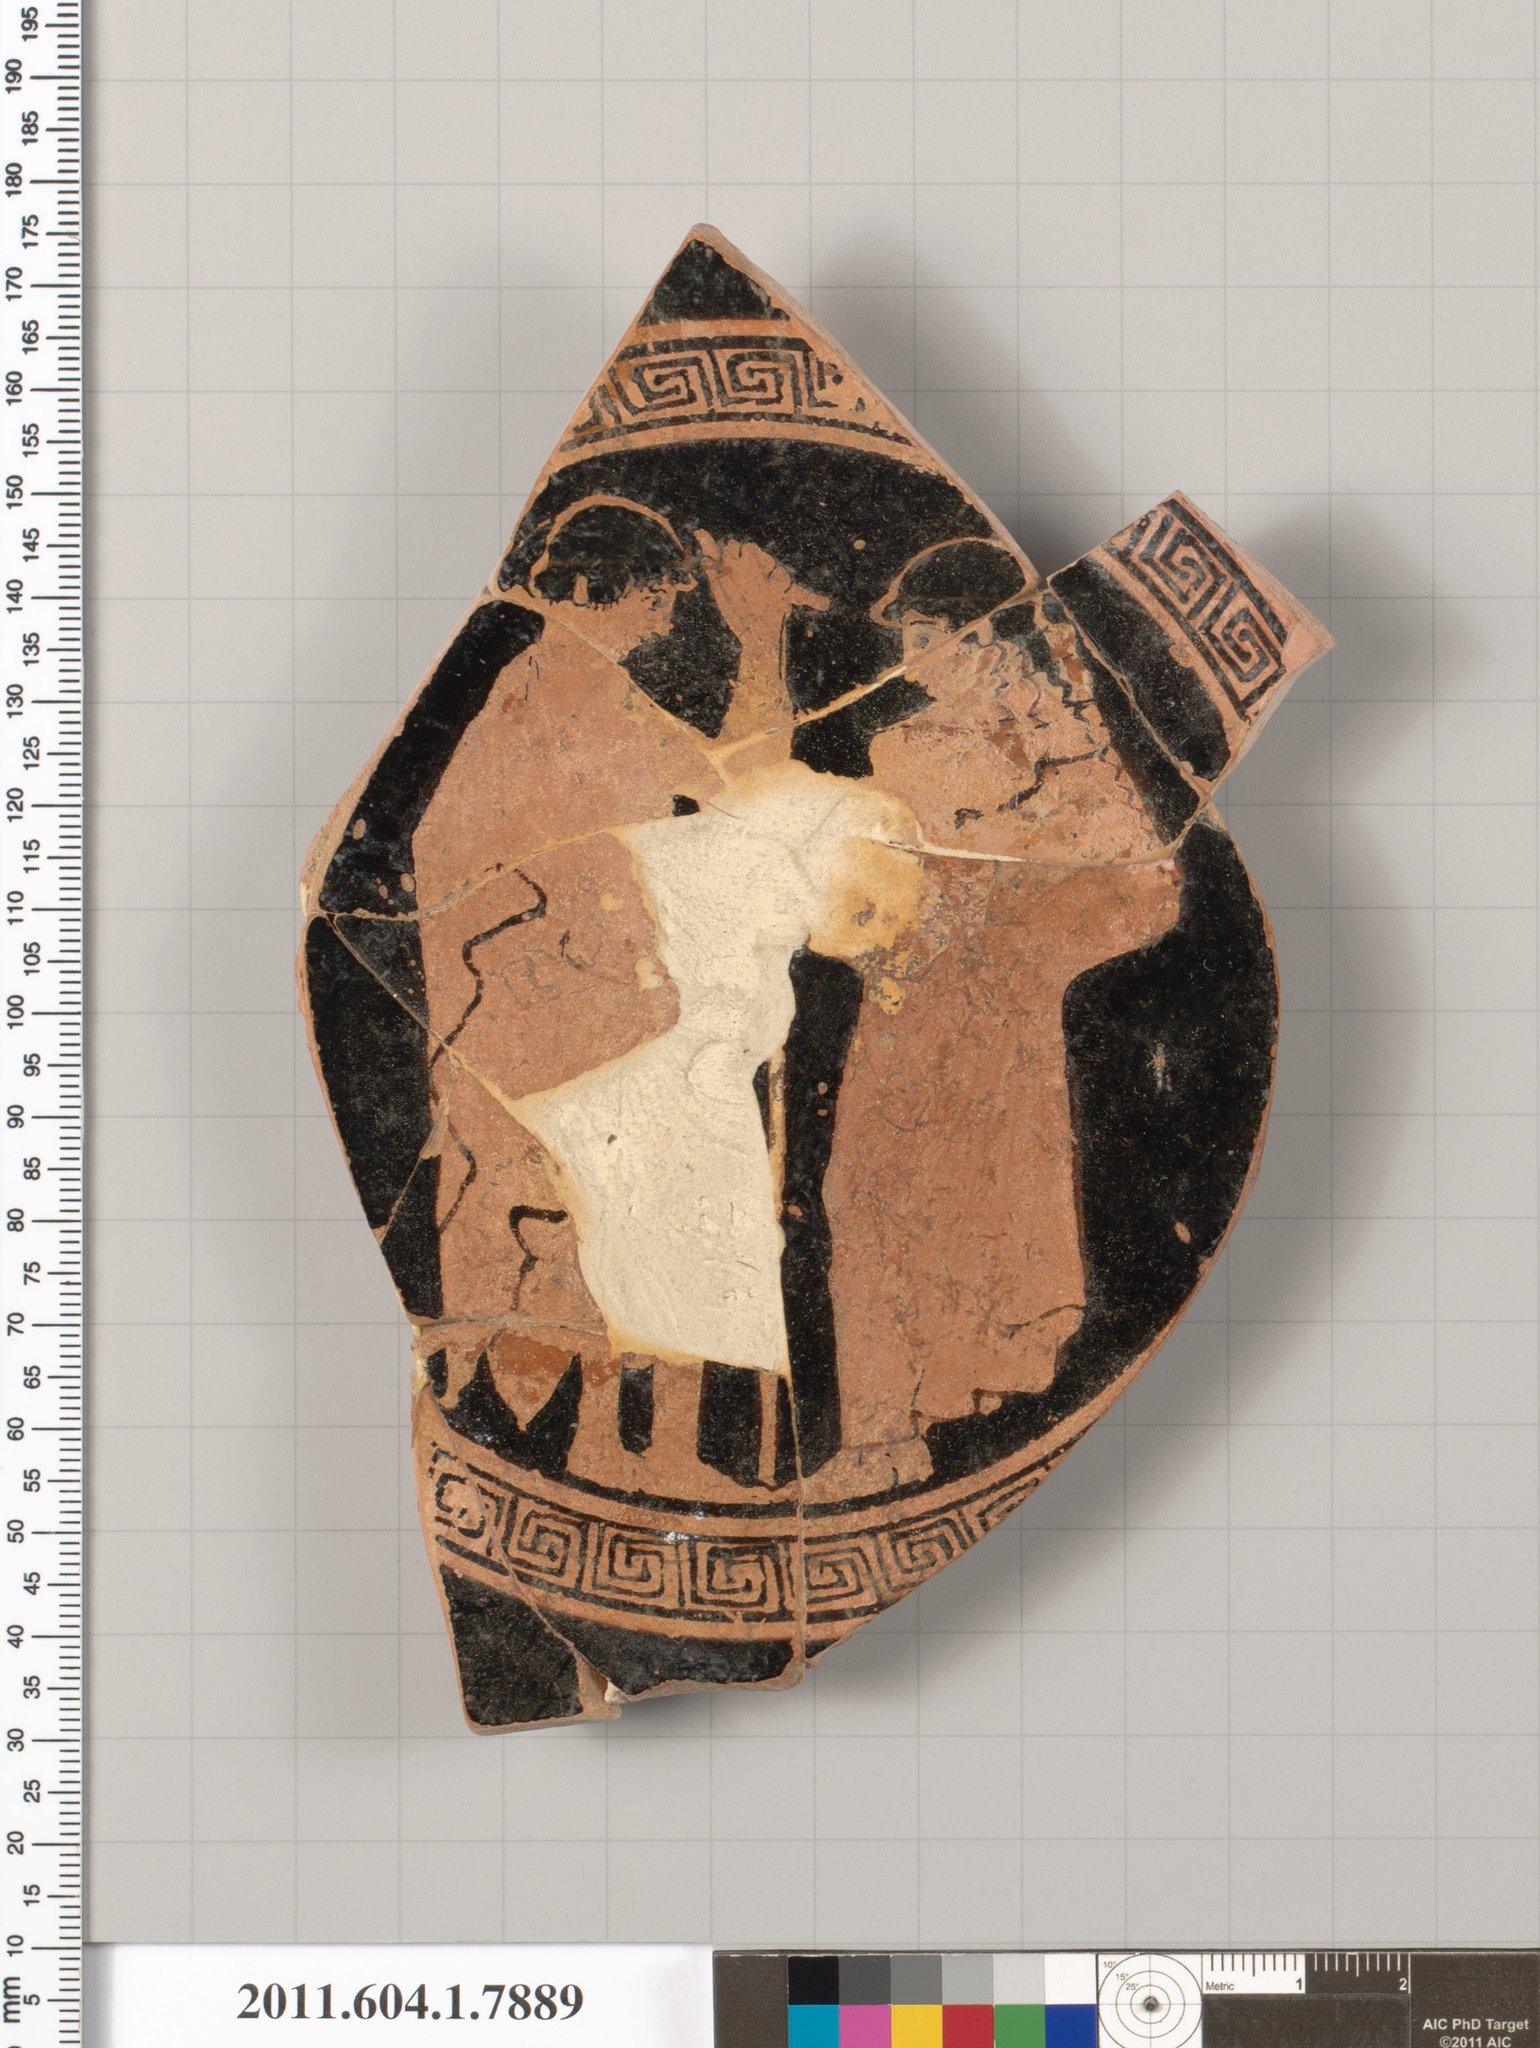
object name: kylix fragment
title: Terracotta fragment of a kylix (drinking cup)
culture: greek, attic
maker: wedding painter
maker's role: artist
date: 460-450 BCE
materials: terracotta